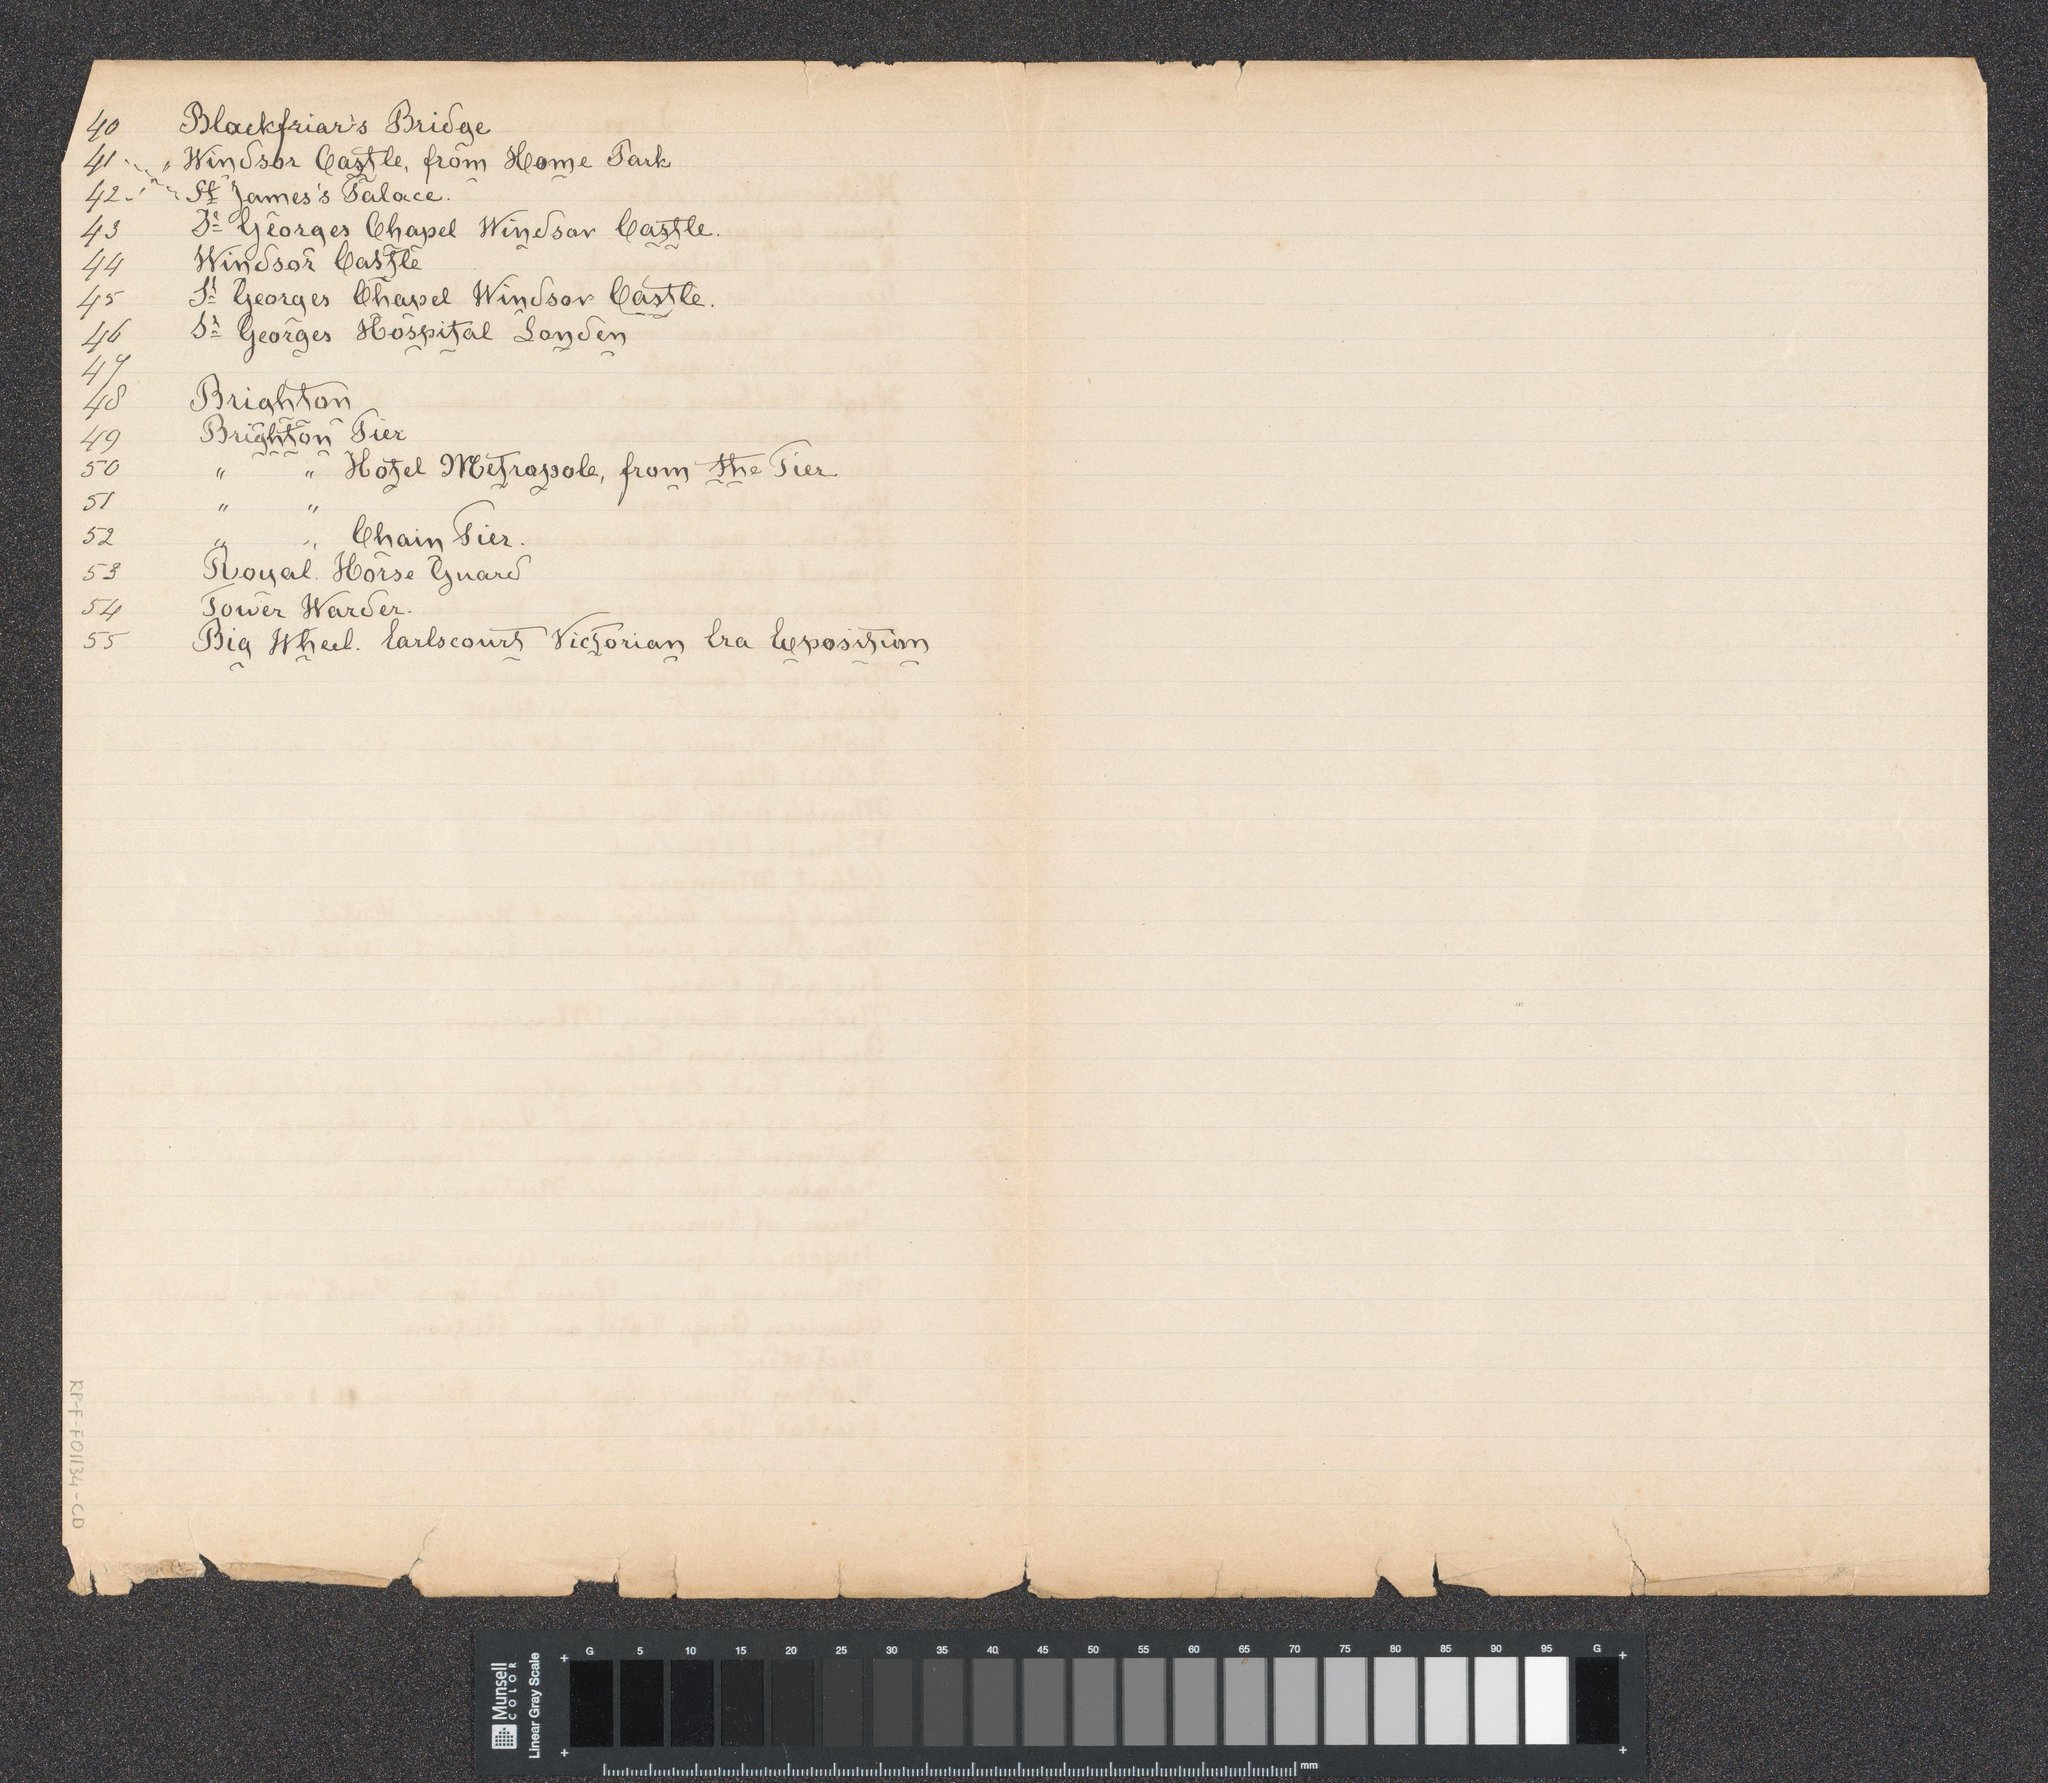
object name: list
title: Lijst met in het album afgebeelde onderwerpen in Londen, Brighton en Windsor (40 t/m 55)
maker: Anonymous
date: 1880-1910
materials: paper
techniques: writing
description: Onderdeel van Reisalbum met bezienswaardigheden in Engeland, Zwitserland, Frankrijk en Duitsland.